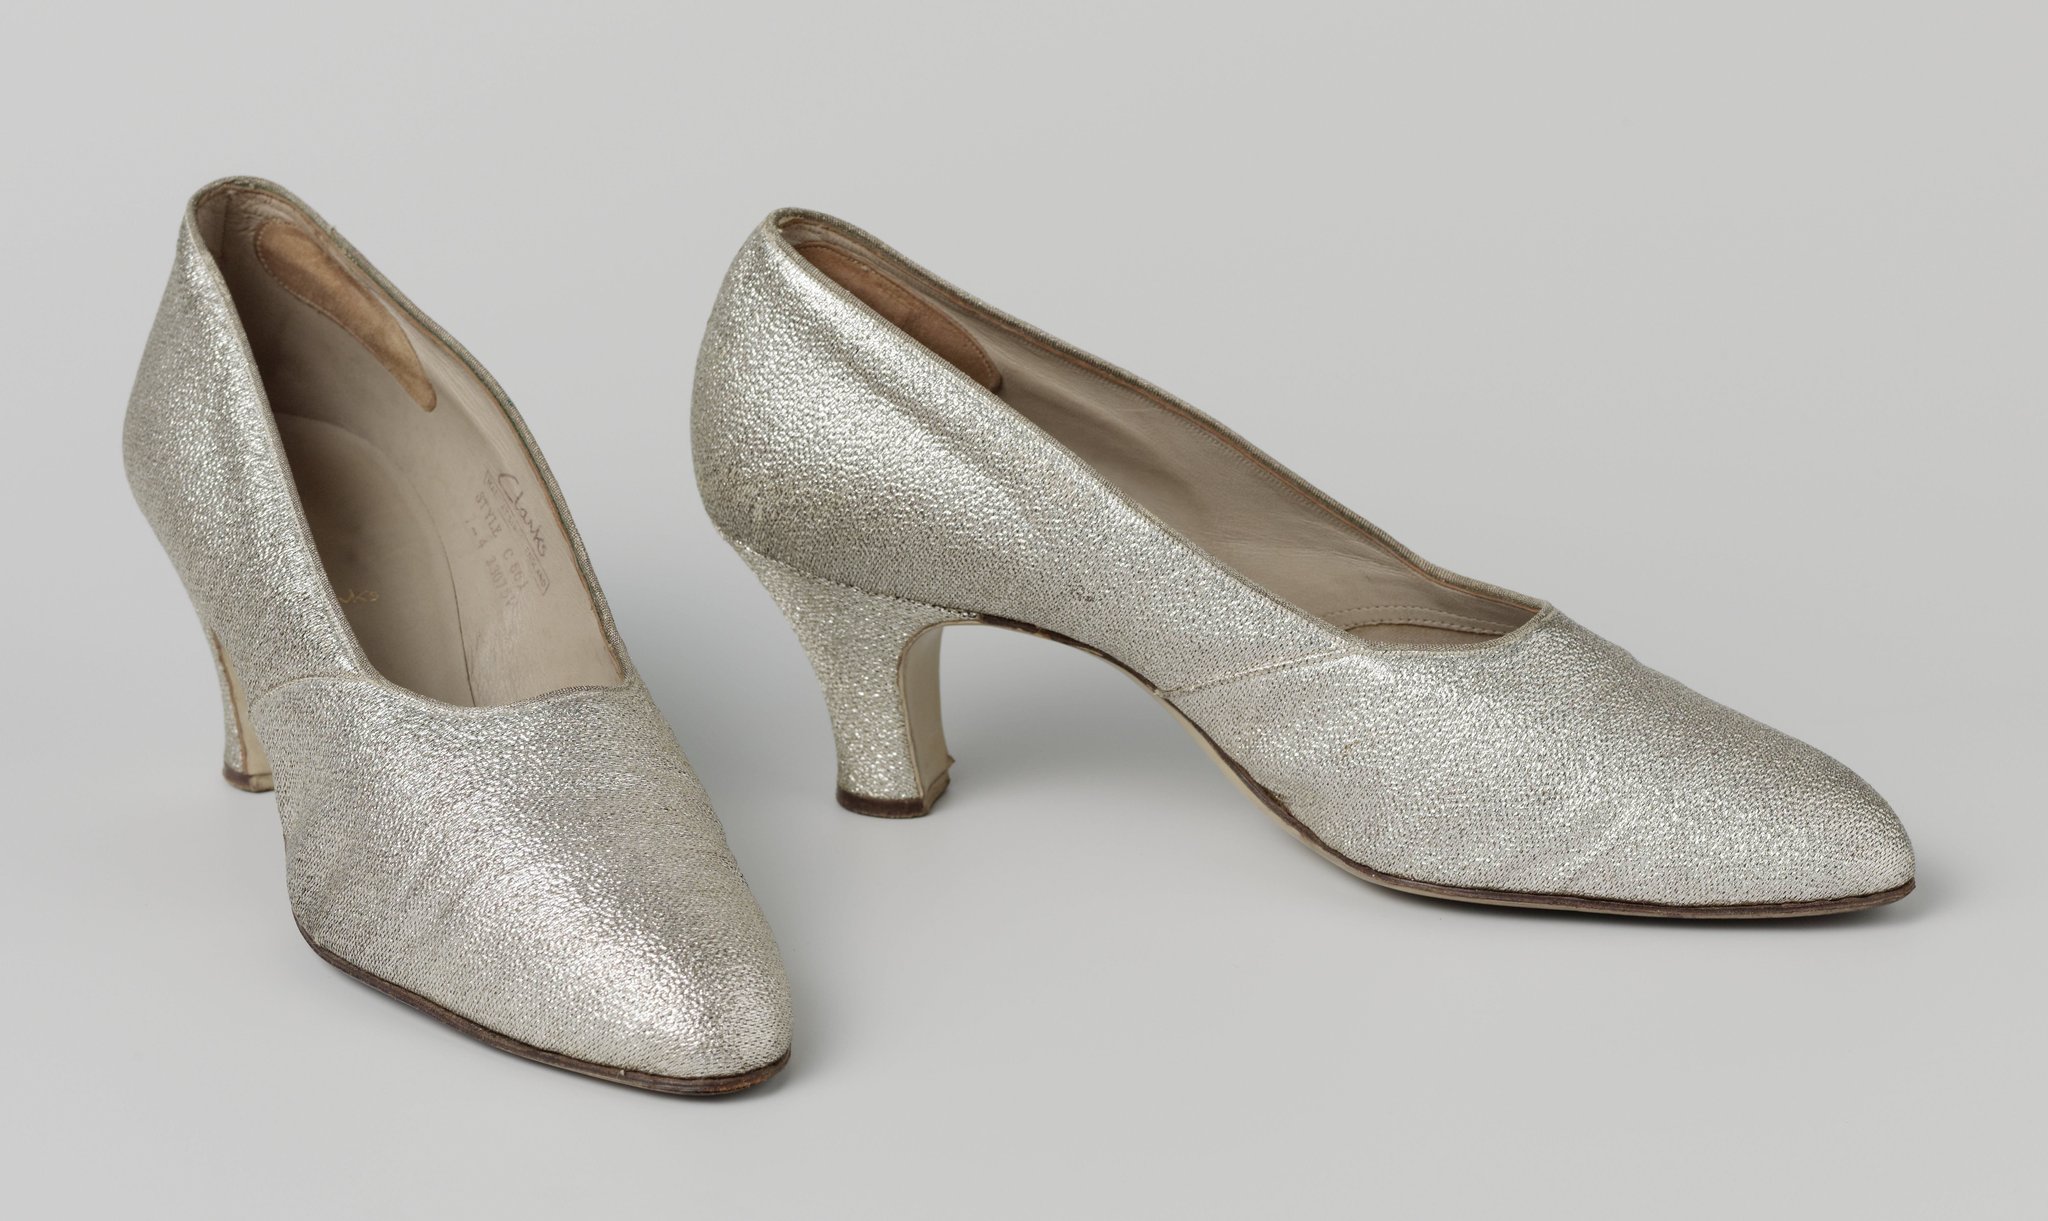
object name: avondschoen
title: Avondschoen van zilverbrokaat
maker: clarks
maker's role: schoenenfabrikant, schoenmaker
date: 1930-1940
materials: leather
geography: street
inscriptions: name: ‘Clarks’, address: ‘C. en J./MADE AT STREET/ENGLAND/CLARK’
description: Linkeravondschoen van zilverbrokaat. Pump met afgeronde, spitse neus en vrij hoge en dikke hak. De hakken zijn bekleed, met hol front en een hoefijzervormig zooltje. Brokaten bovenstuk bestaat uit drie delen, vrij grof zonder enige versiering. Adres (van binnen): Clarks, (op de zool): C. en J./MADE AT STREET/ENGLAND/CLARK in een (gesleten) ronde stempel.